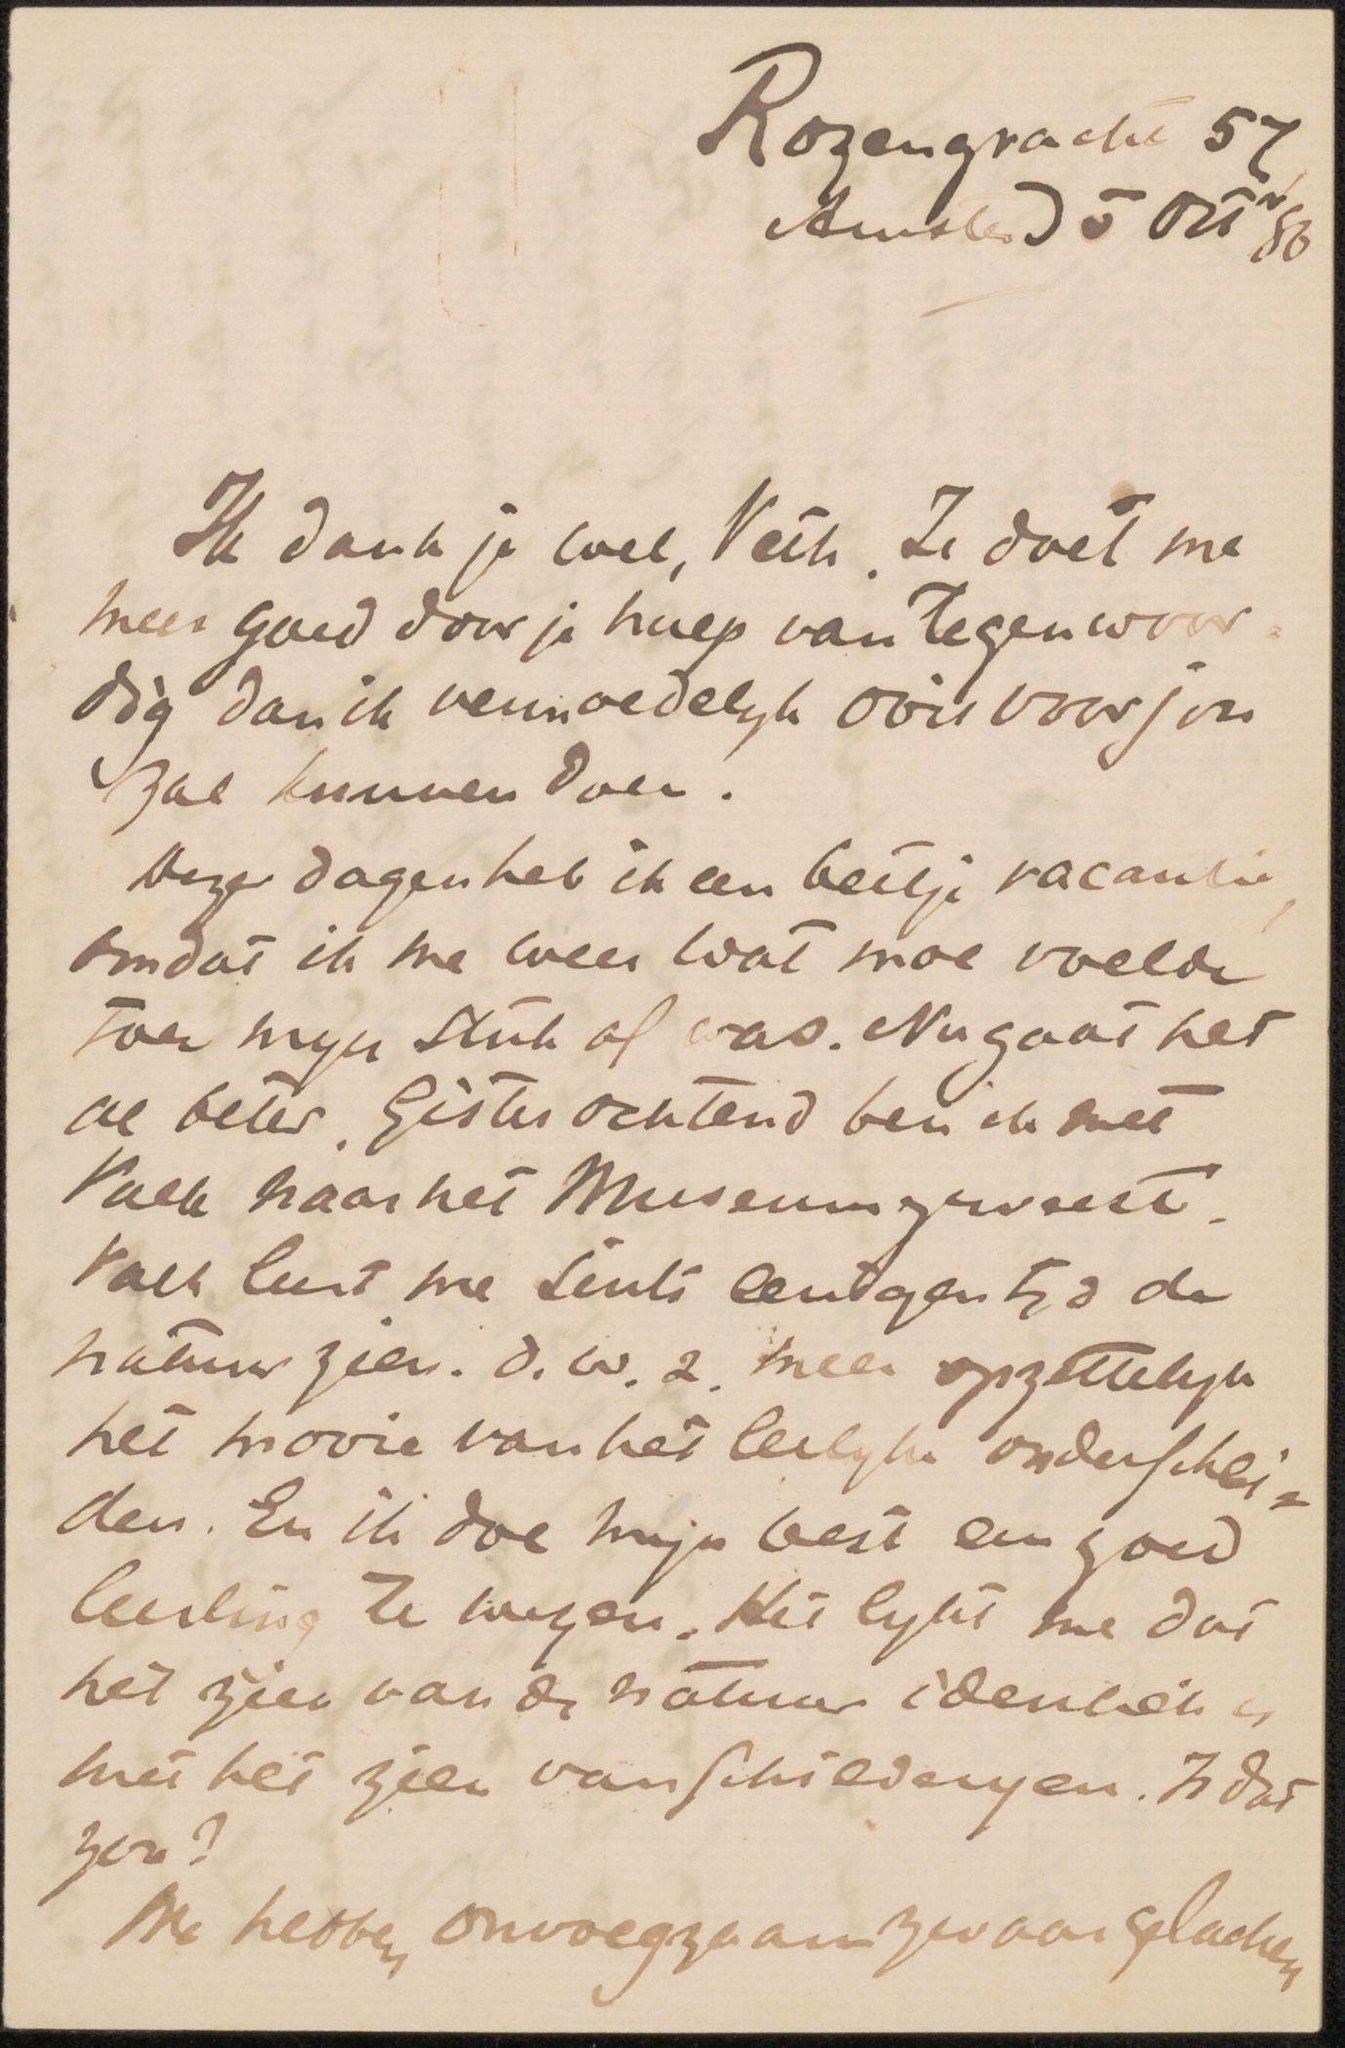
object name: letter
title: Brief aan Jan Veth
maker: albert verwey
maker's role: criticus, dichter, essayist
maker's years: 1865-1937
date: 1886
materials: ink, paper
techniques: pen, writing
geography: amsterdam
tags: william shakespeare, rotterdam, george hendrik breitner, dordrecht, designer, jan veth, jan hoynck van papendrecht, the hague, painter, draughtsman, willem maris, arnhem, anton mauve, jacob maris, utrecht, albert neuhuys (1844-1914), maastricht, antonie frederik zürcher, maurits van der valk, den bosch, antoon derkinderen, amsterdam, print maker, willem bastiaan tholen, wally moes, zeist, rijksmuseum amsterdam, the graphic arts, painting (including book-illumination, miniature-painting), historical persons (portraits and scenes from the life)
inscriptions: collector's mark: ‘RPK’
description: Opgenomen in: Verwey, Albert, Margaretha H. Schenkeveld, Rein van der Wiel: Briefwisseling 1 juli 1885 tot 15 december 1888, Amsterdam: EM. Querido's Uitgeverij B.V., 1993, p. 230-232.